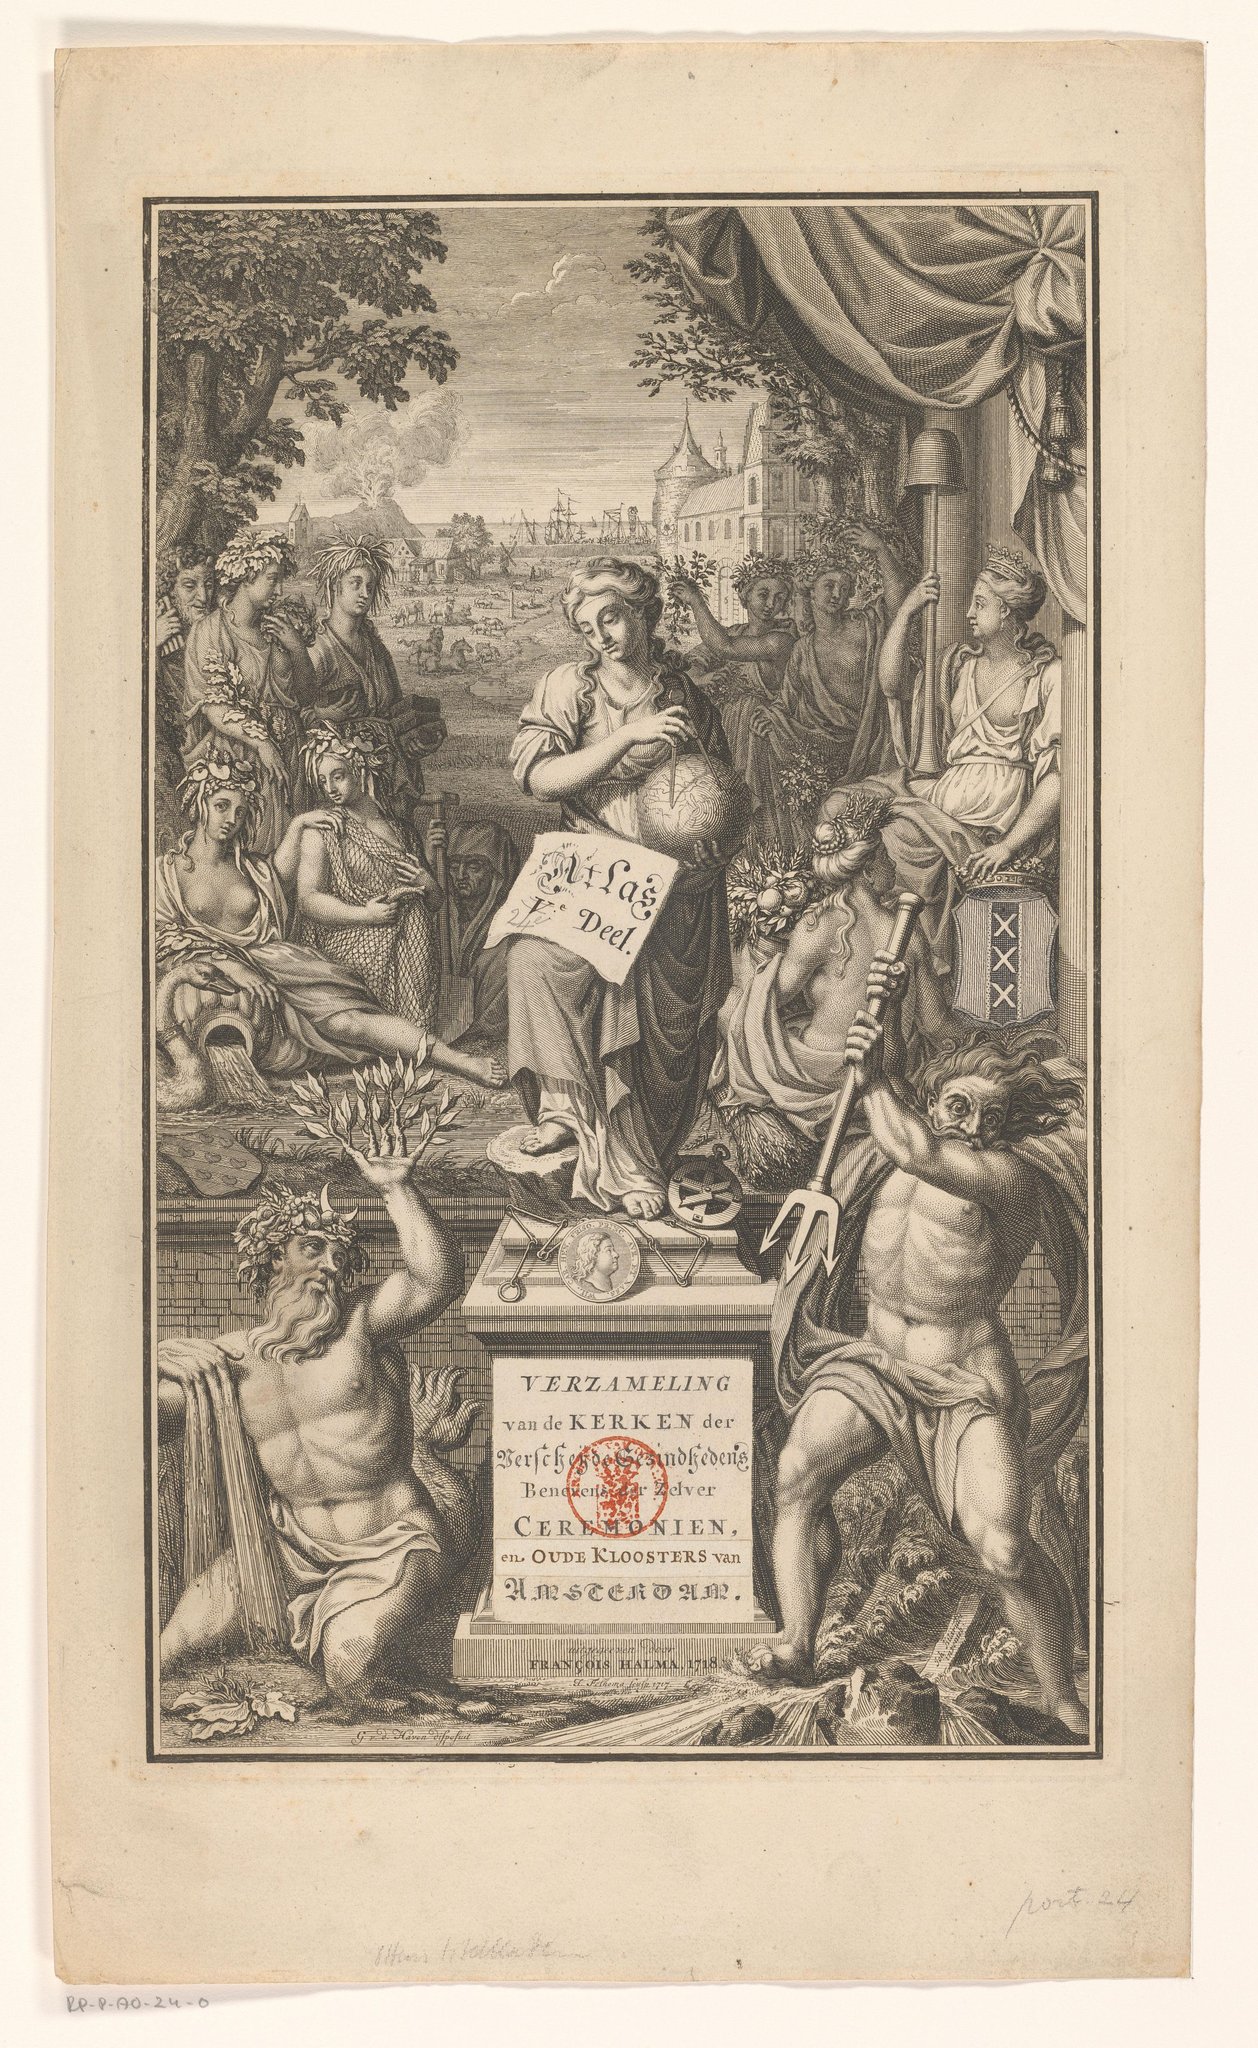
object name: titelprent, frontispice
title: Verzameling van de Kerken der Verscheijde Gezindhedens Benevens der Zelver Ceremonien, en Oude Kloosters van Amsterdam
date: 1717-1718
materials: ink, paper, pencil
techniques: engraving, etching, pen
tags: commercial fishery, (story of) ceres (demeter), coat of arms (as symbol of the state, etc.) (+ city; municipal), peat-cutting, 'astronomia', 'cosmografia'; 'cosmografia' (ripa), personifications of countries, nations, states, districts, etc., river-gods, 'corografia', 'geografia', 'hidrografia' (ripa), agriculture, fruitfulness, productiveness, fertility, fecundity; 'fecondità' (ripa), (story of) flora, neptune as lord of the sea, amsterdam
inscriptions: collector's mark: Lugt 19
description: Deze prent is hier gebruikt als titelprent van een deel van een ongebonden atlas; een verzameling cartografische en topografische prenten en tekeningen. Oorspronkelijk was de prent echter bedoeld als titelpagina voor een gebonden atlas met kaarten van Friesland, waardoor een deel van de hier volgende beschrijving betrekking heeft op die context. Op het voetstuk in het midden staat de personificatie van de cartografie, met in haar hand een aardbol die ze met een passer meet. Op haar bovenbeen rust een blad met het handgeschreven deel van de atlas (oorspronkelijk een kaart van Friesland). Aan haar voeten een meetketting, een rond (land)meetkundig instrument en een portret van Willem IV van Oranje-Nassau. Daaronder de handgeschreven titel van dit deel van de atlas. Ze houdt een wakend oog op Wispelturigheid (Wispeltuer), linksonder. Oorspronkelijk staat hij voor de wispelturigheid waar het Friese land zich naar moest schikken: een bos kon opeens onder water staan, want zijn lichaam smelt door het zoute water van de zee. Linksboven zijn hoofd een wapenschild met het wapen van Friesland (met schuinbalken en pompeblêden). De dreiging van de zee is rechtsonder verbeeld door een onstuimige Neptunus (Zeevoogd). Links en rechts van Cartografie nog meer figuren die oorspronkelijk betrekking hadden op Friesland en haar vruchtbare natuur, visserij en landbouw. Links, met haar arm leunend op een kruik waar water uitstroomt, een stroomgodin (Stroomvoogdess) met rechts van haar de personificatie van de visserij (Visschevang). Boven hen van links naar rechts: een sater met fluit als personificatie van de natuur (Natuer), de personificatie van de bossen met eikenloven (Woudman) en personificatie van de turfwinning (vrouw Veenbrand). Rechtsonder haar vrouw Onland, die rouwt om de schade die de turfwinning aan het land veroorzaakt. Rechts van Cartografie zit Flora en/of Ceres (vrouw Veldgewas) met korenaren en cornucopia, ze staat voor de overvloed die voortvloeit uit het land. Boven haar, op de achtergrond, twee vrouwelijke personificaties die in verband staan met groene weides en/of grasvelden: Beemdeheil en Graazevol. Rechts, met in haar ene hand een bazuin met daarop een vrijheidshoed en in de andere hand een schild met het wapen van Amsterdam, de personificatie van het gebied van dit deel van de atlas (oorspronkelijk de Friese Maagd met het provinciewapen met twee leeuwen). Op de achtergrond een landschap met kenmerkende Friese elementen, zoals het Sjaerdemaslot te Franeker en de vuurspuwende Rode Klif te Gaasterland (zou in de oudheid een vulkaan zijn geweest).